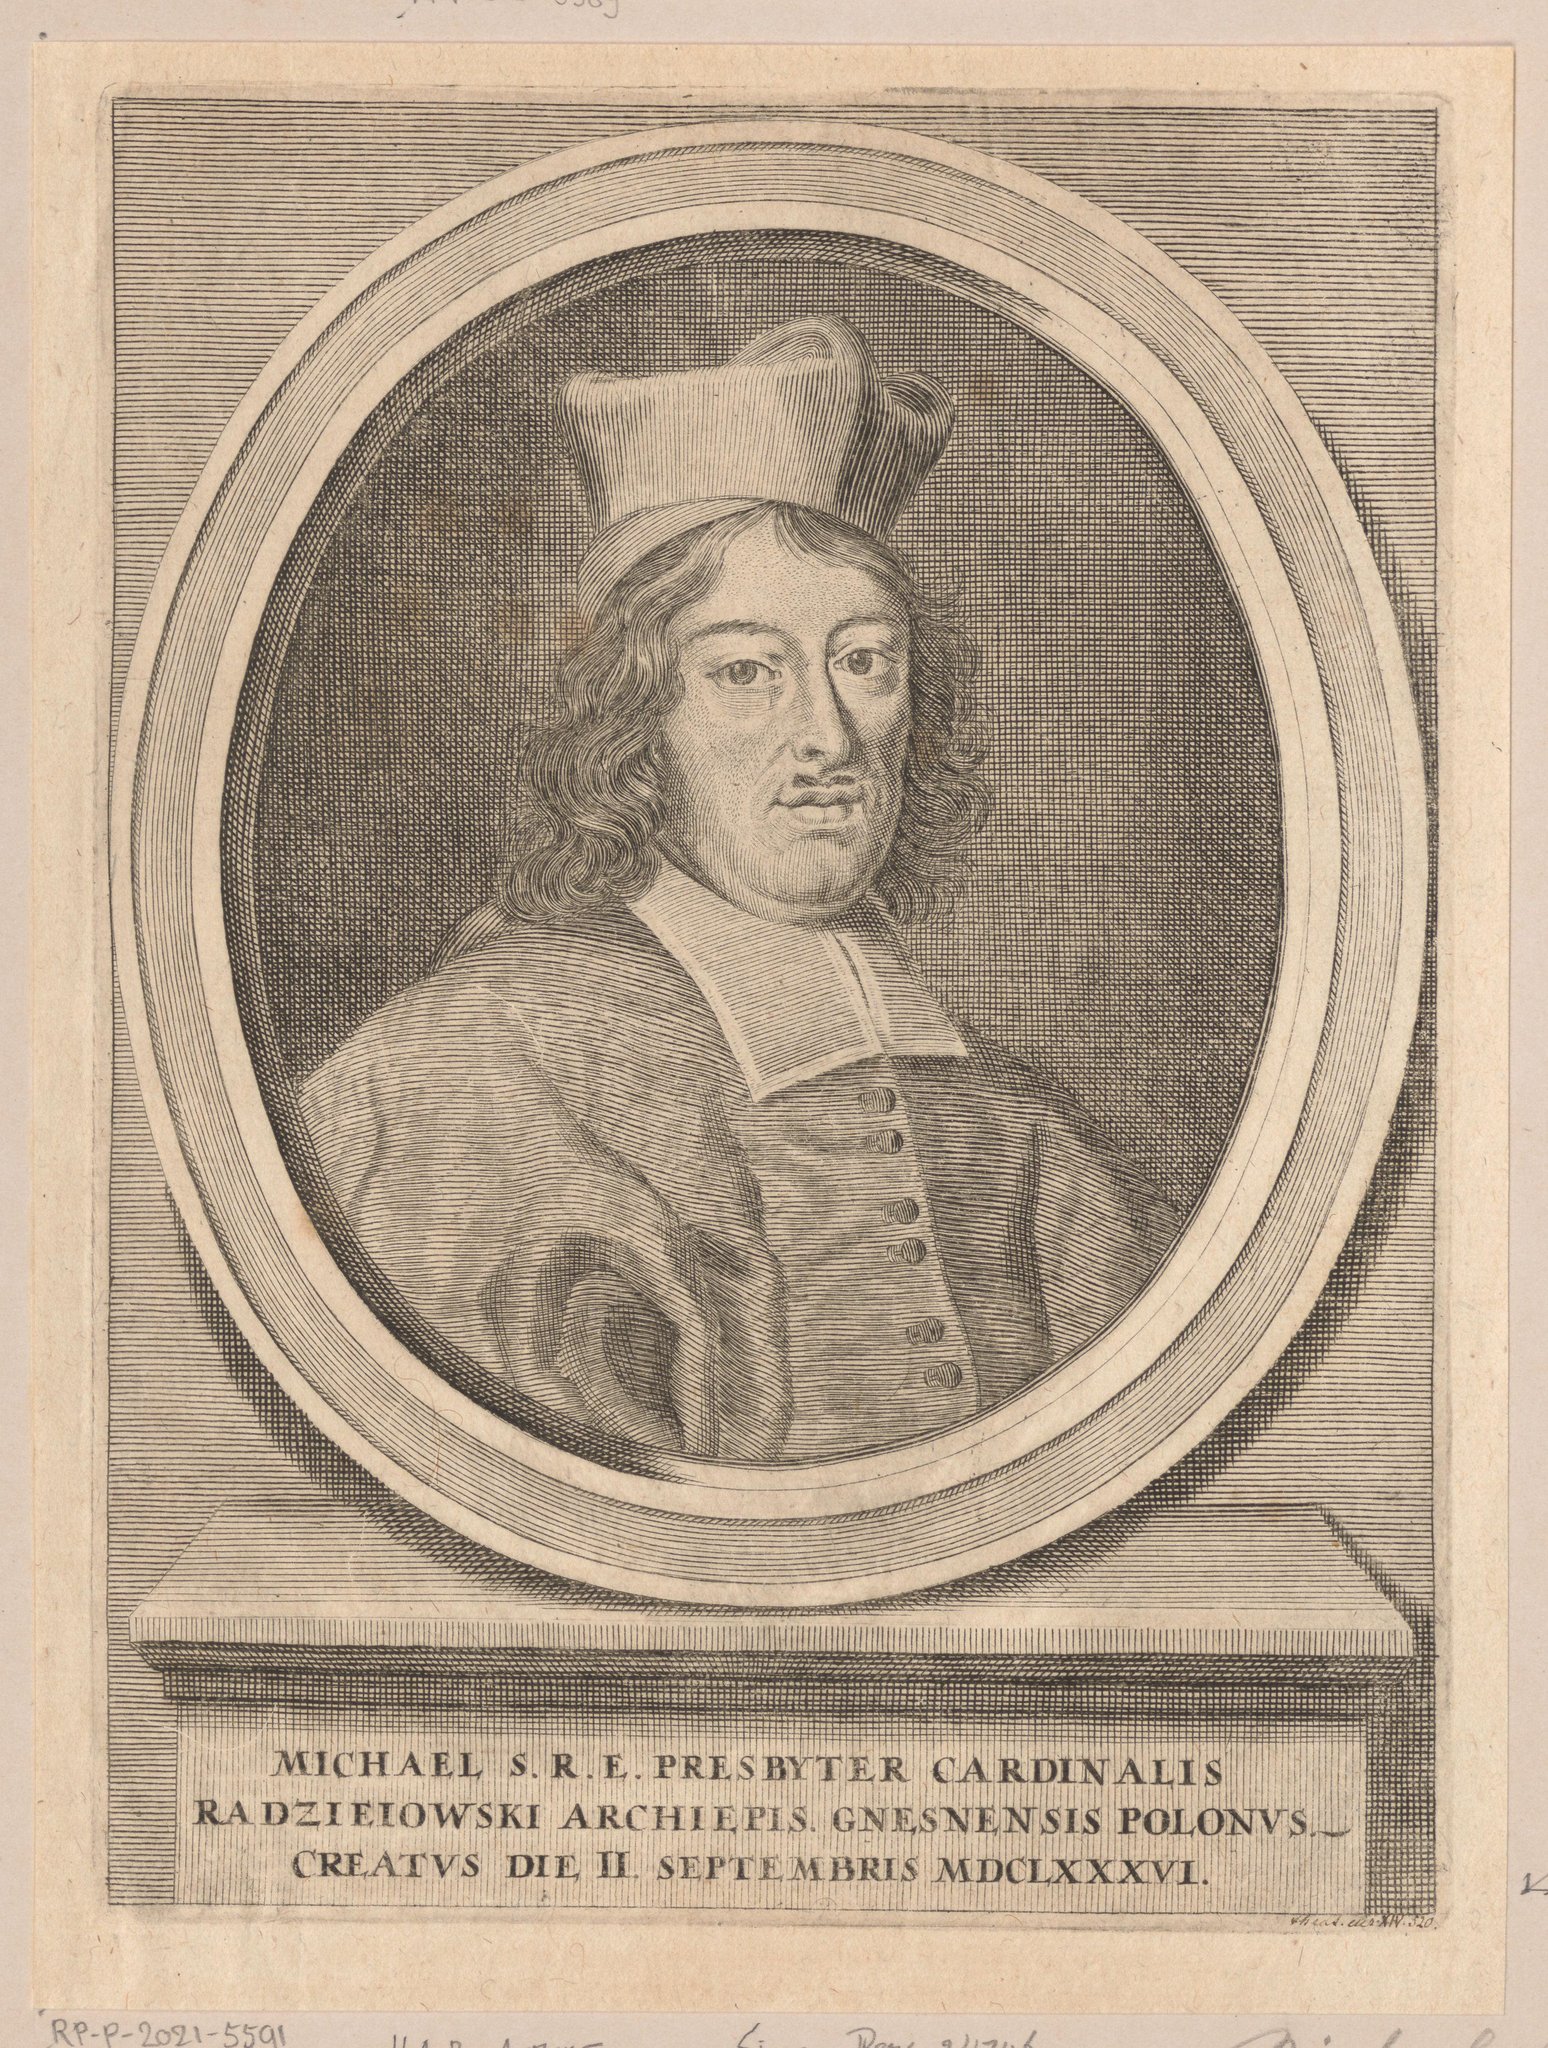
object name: print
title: Portret van Michael Stephan Radziejowski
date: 1686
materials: paper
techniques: engraving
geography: frankfurt am main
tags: clergyman, archbishop, bishop, etc. (roman catholic), historical persons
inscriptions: date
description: Prent mogelijk uit: Theatrum Europaeum (...). Frankfurt am Main: erven Matthäus Merian I, 1702. Of een latere publicatie (1717).